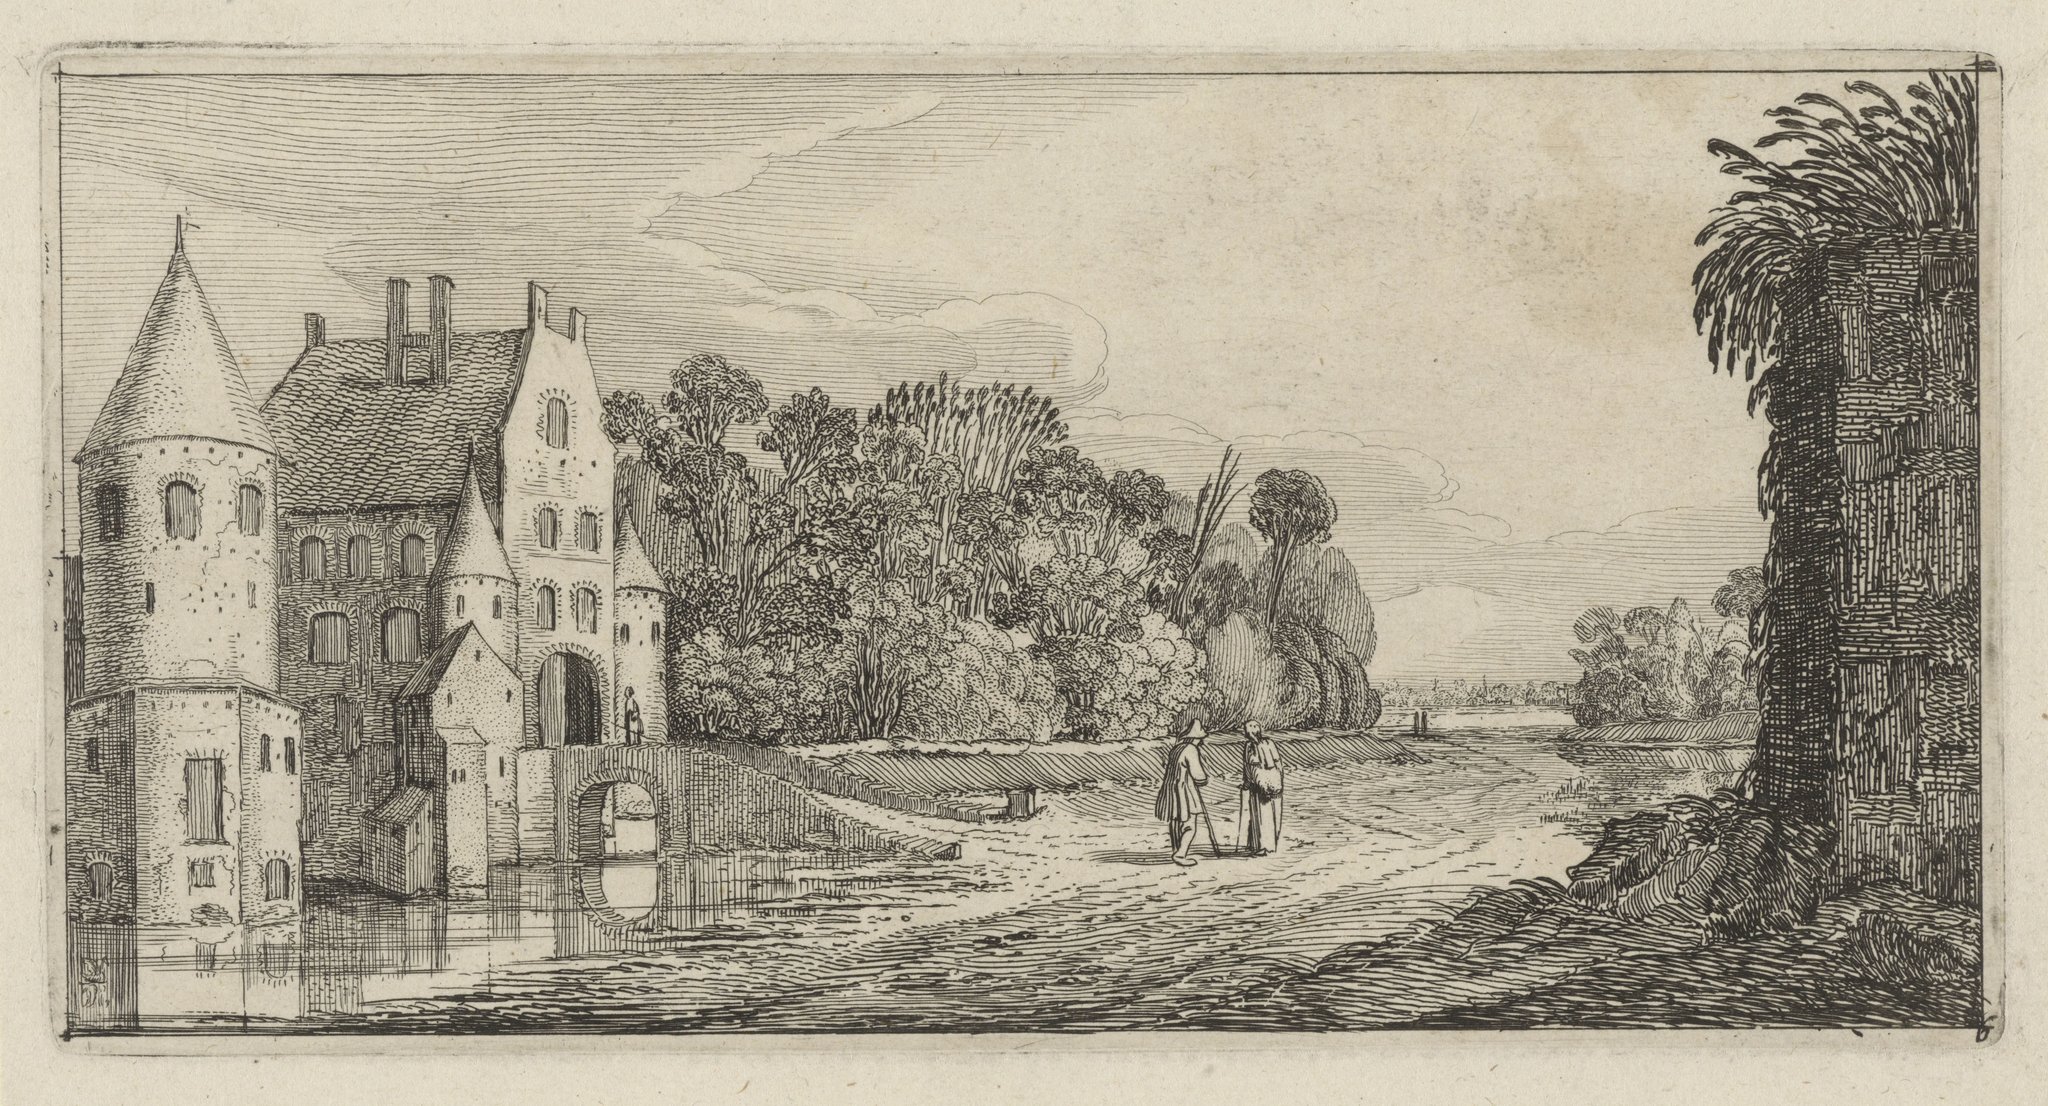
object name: print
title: Vlakke landschappen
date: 1605-1652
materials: paper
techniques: etching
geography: netherlands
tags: castle, conversation, dialogue; conversation piece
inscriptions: collector's mark: Lugt 240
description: Gezicht op een kasteel aan een kanaal. Op de weg naast het kanaal voeren twee figuren een gesprek. De prent maakt deel uit van een serie bestaande uit acht vlakke landschappen.